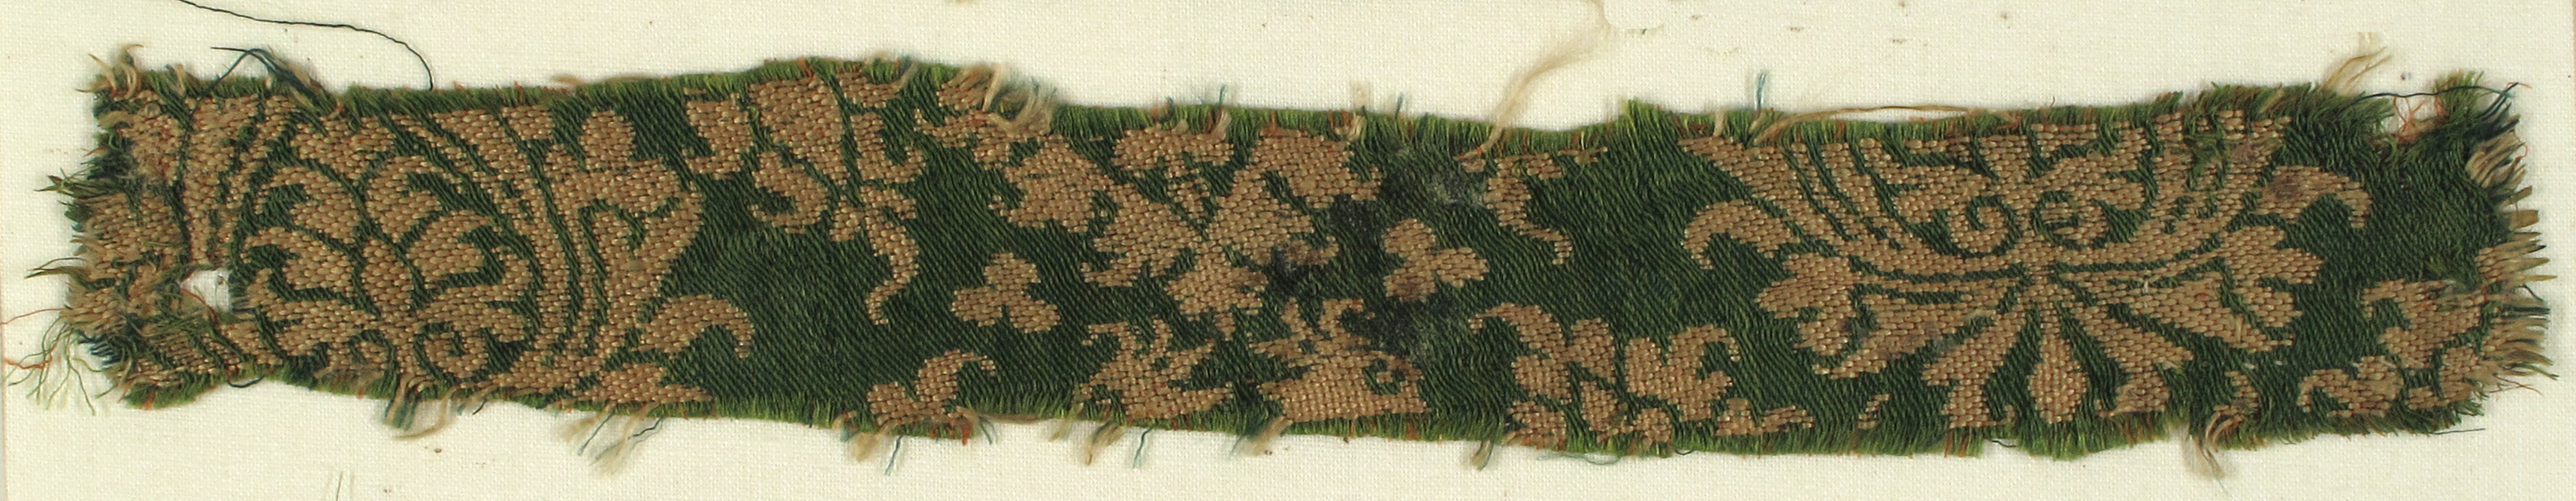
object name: textile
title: Textile with Figures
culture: italian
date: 1301-1400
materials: silk